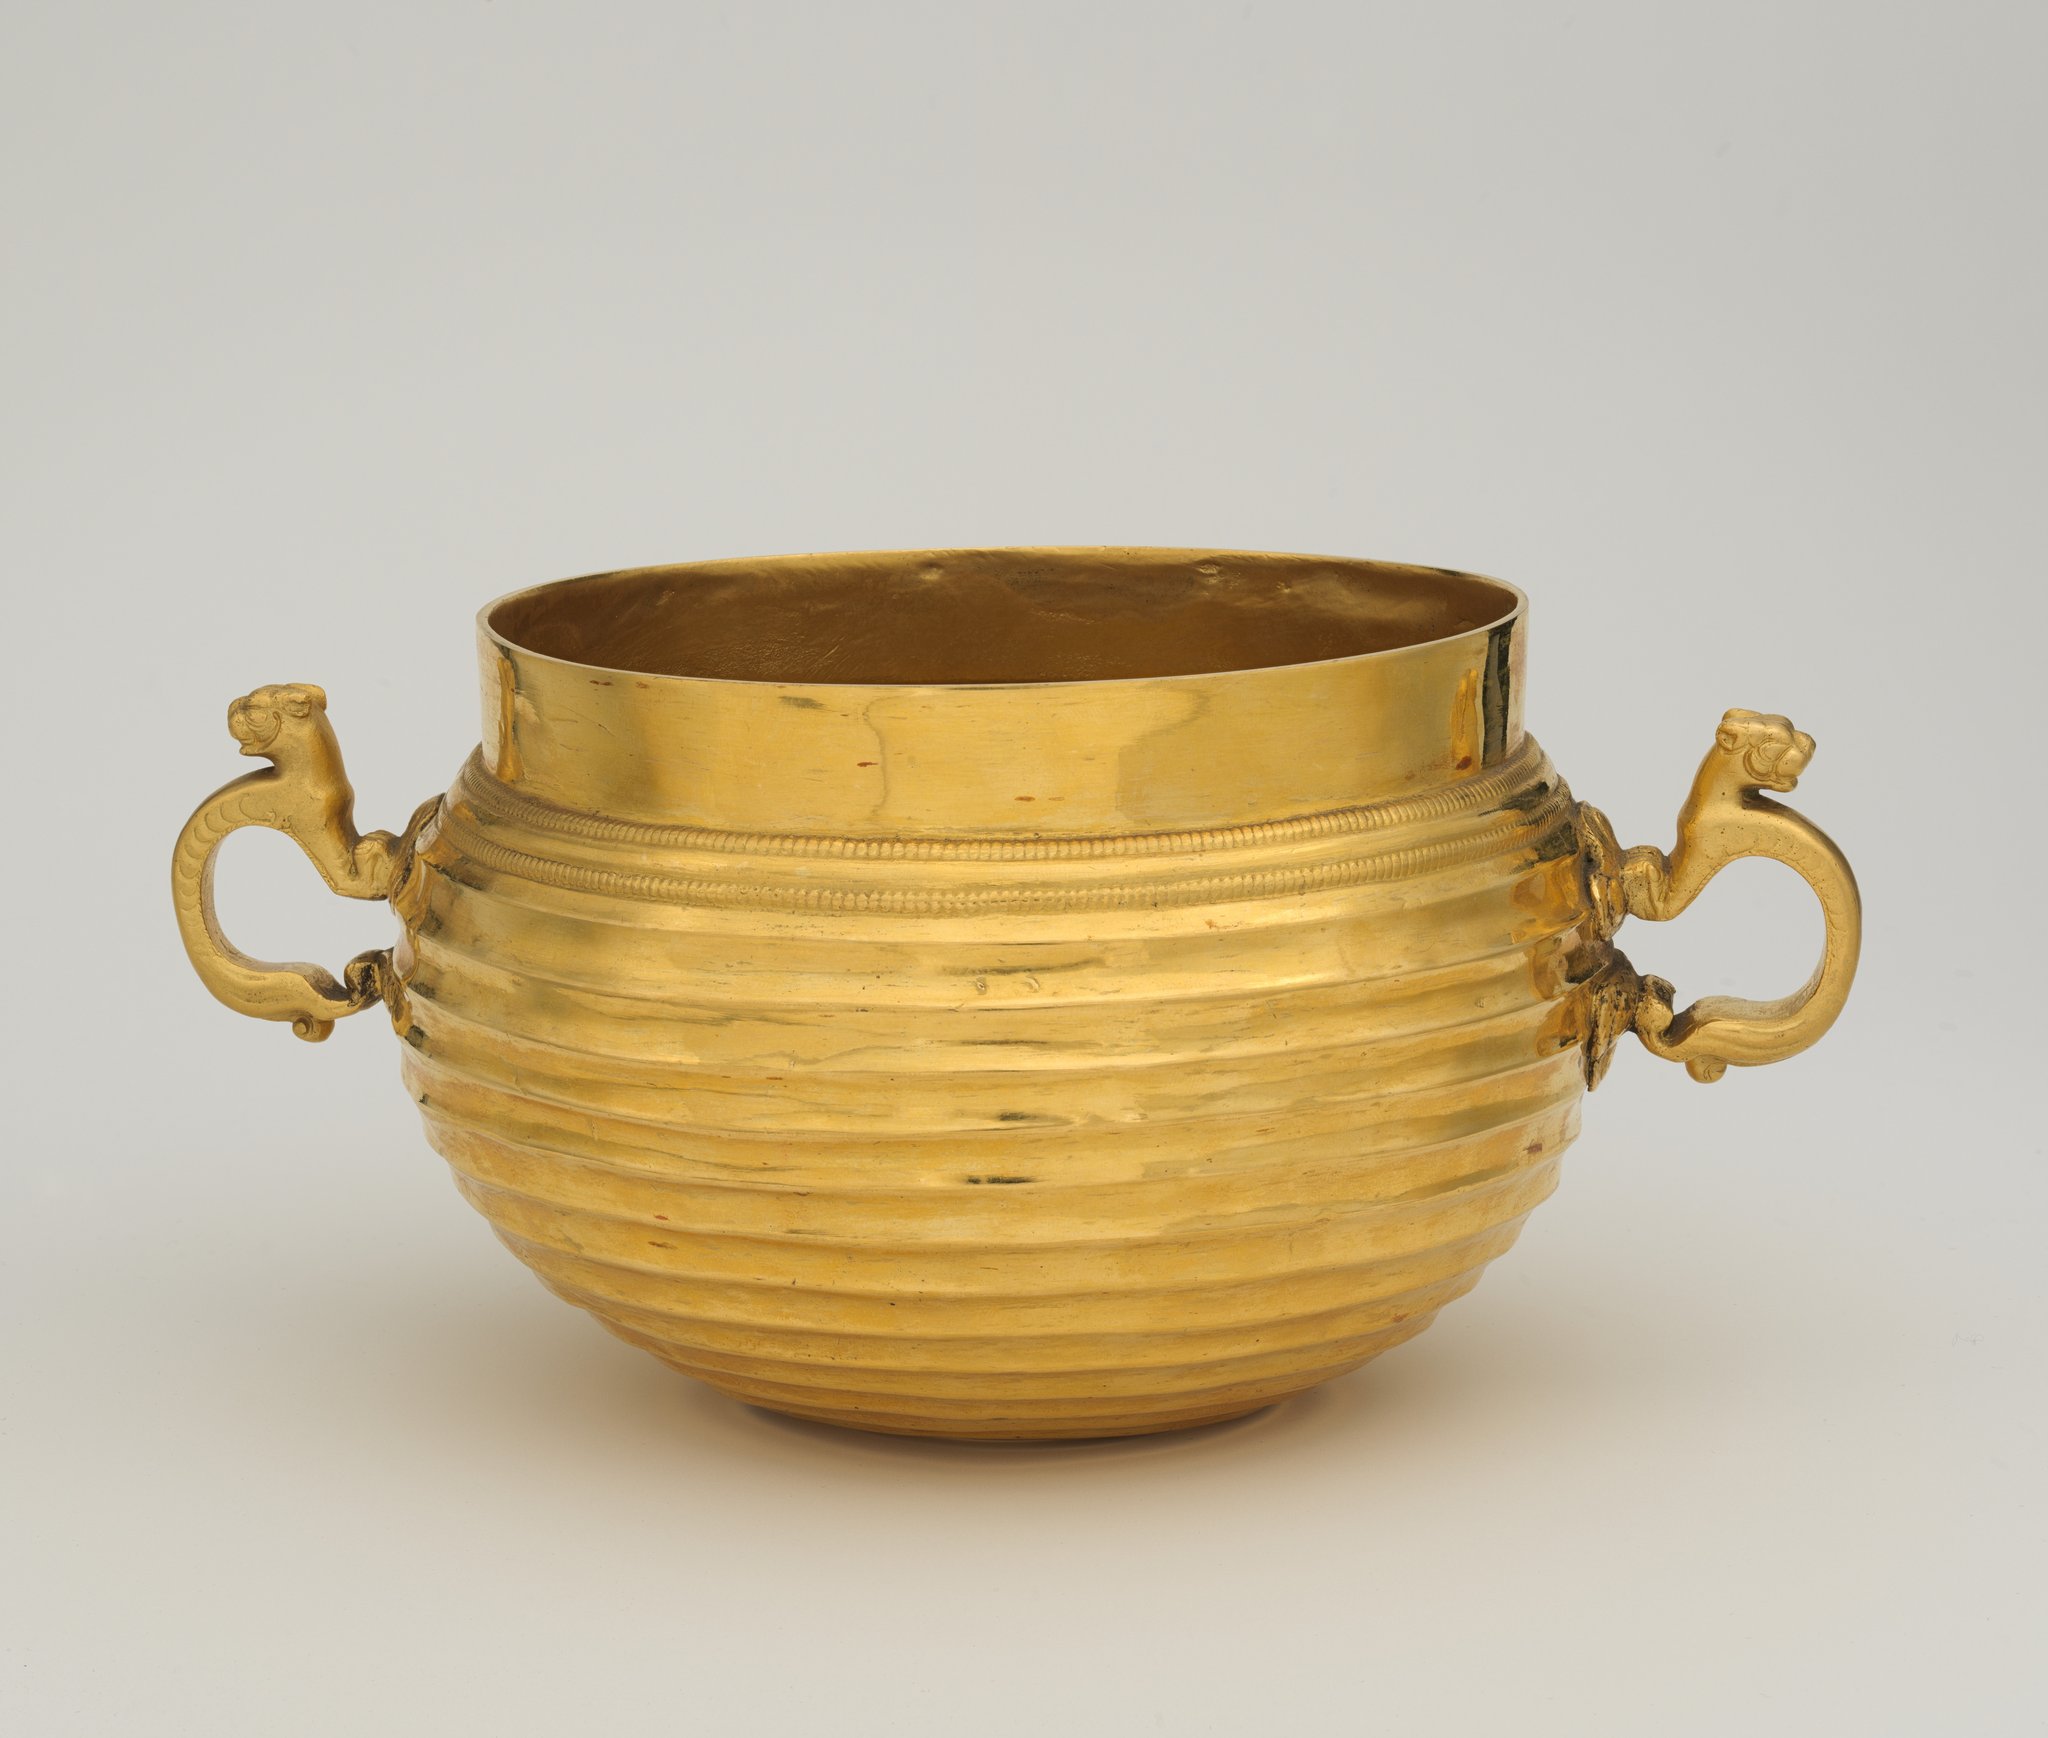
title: Reproduction of a Scythian bowl with animal handles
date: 1801-1900